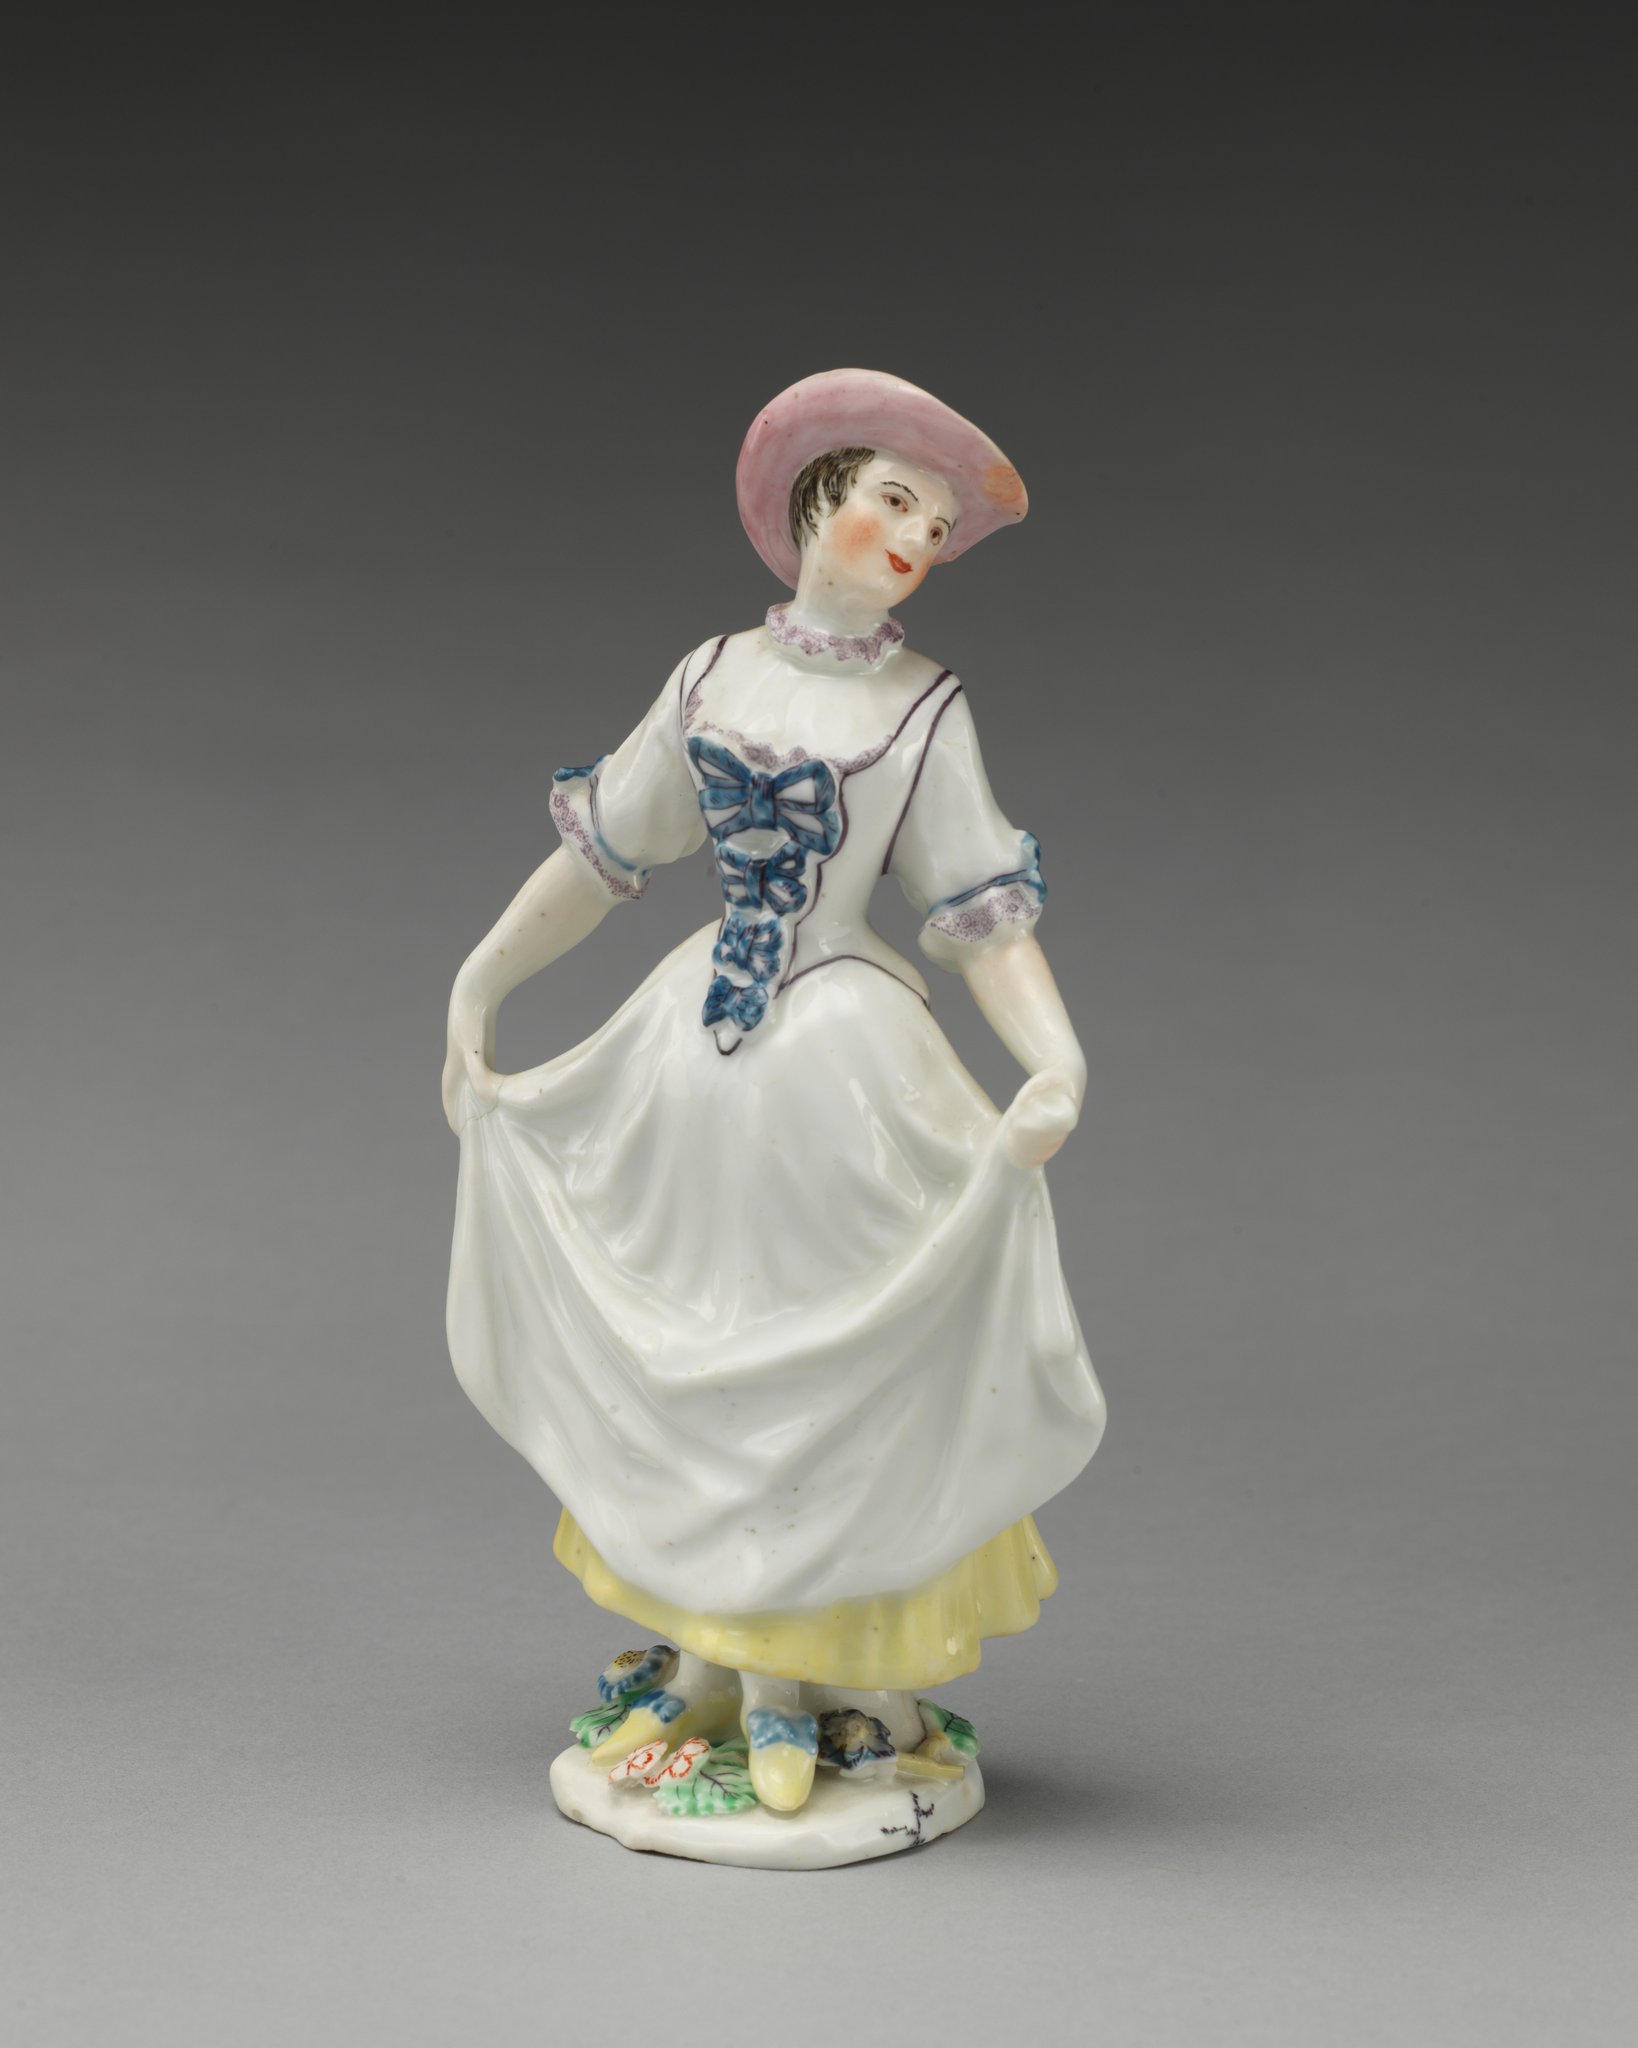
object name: figure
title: Dancing girl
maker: chelsea porcelain manufactory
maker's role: factory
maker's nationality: british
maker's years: 1744-1784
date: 1750-1752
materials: soft paste porcelain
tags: girls,dancing